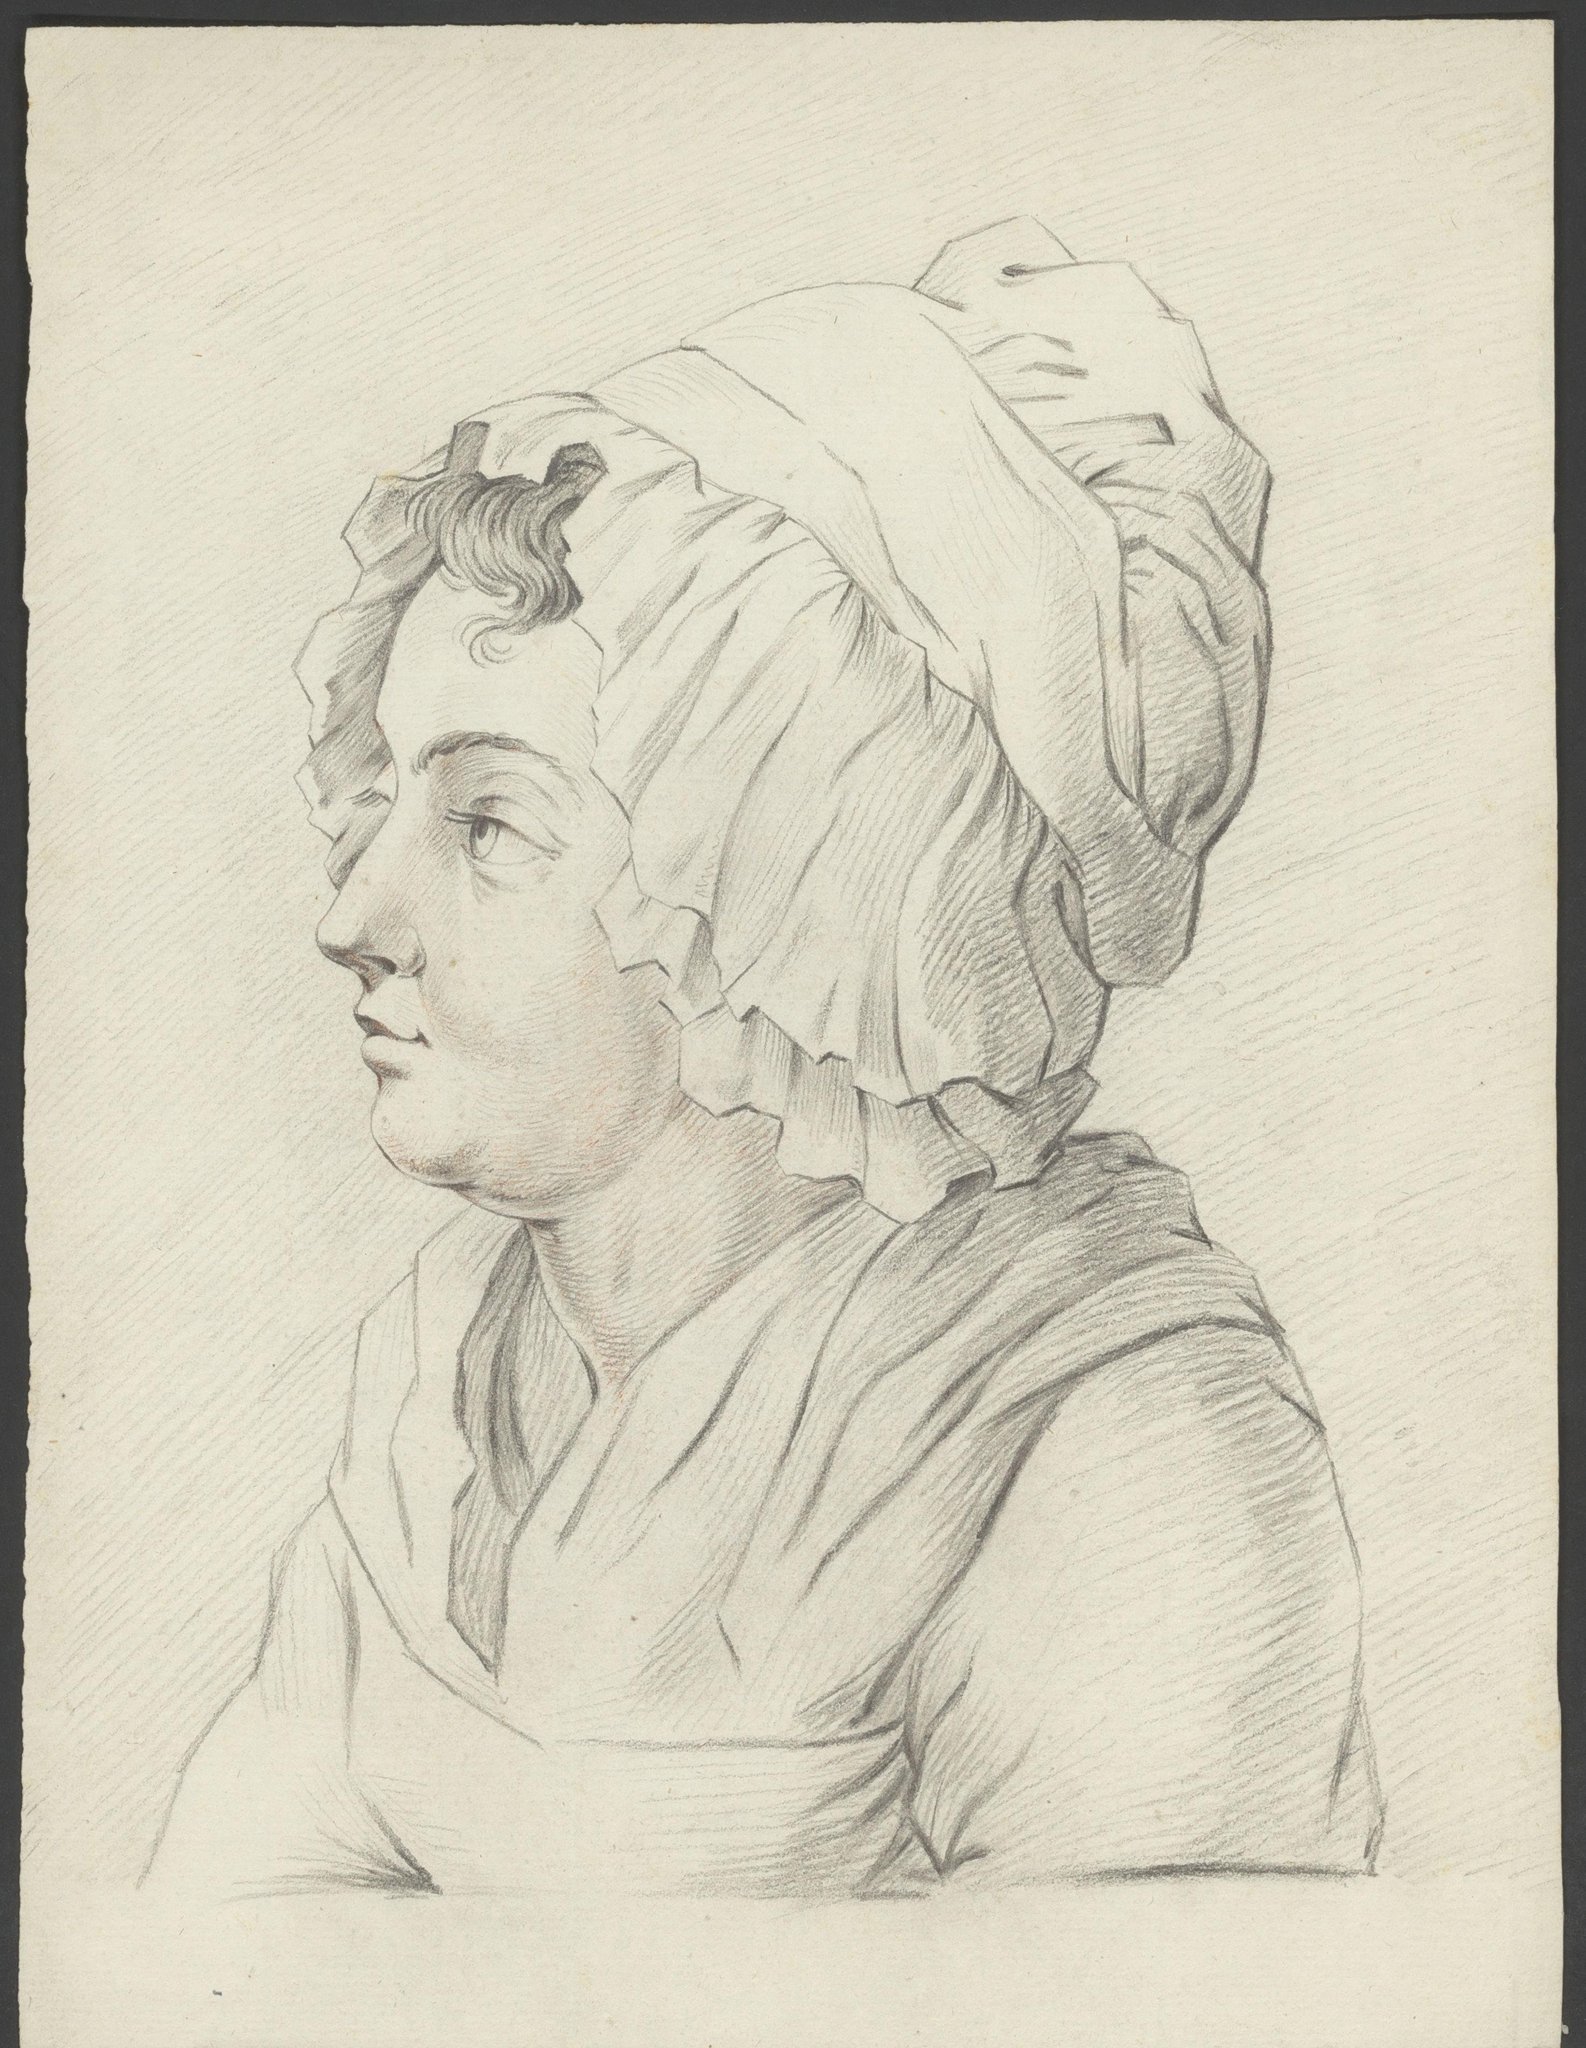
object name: drawing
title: Gezicht van een vrouw met muts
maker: Anonymous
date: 1800-1899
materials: chalk, paper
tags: face, face (+ sideview, profile), head-gear: cap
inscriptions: collector's mark: Lugt 1641, stamp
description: Onderwerpsrubrieken binnen de Atlas Zeden en Gewoonten: Schoone kunsten, Schilderkunst, Tekeningen.